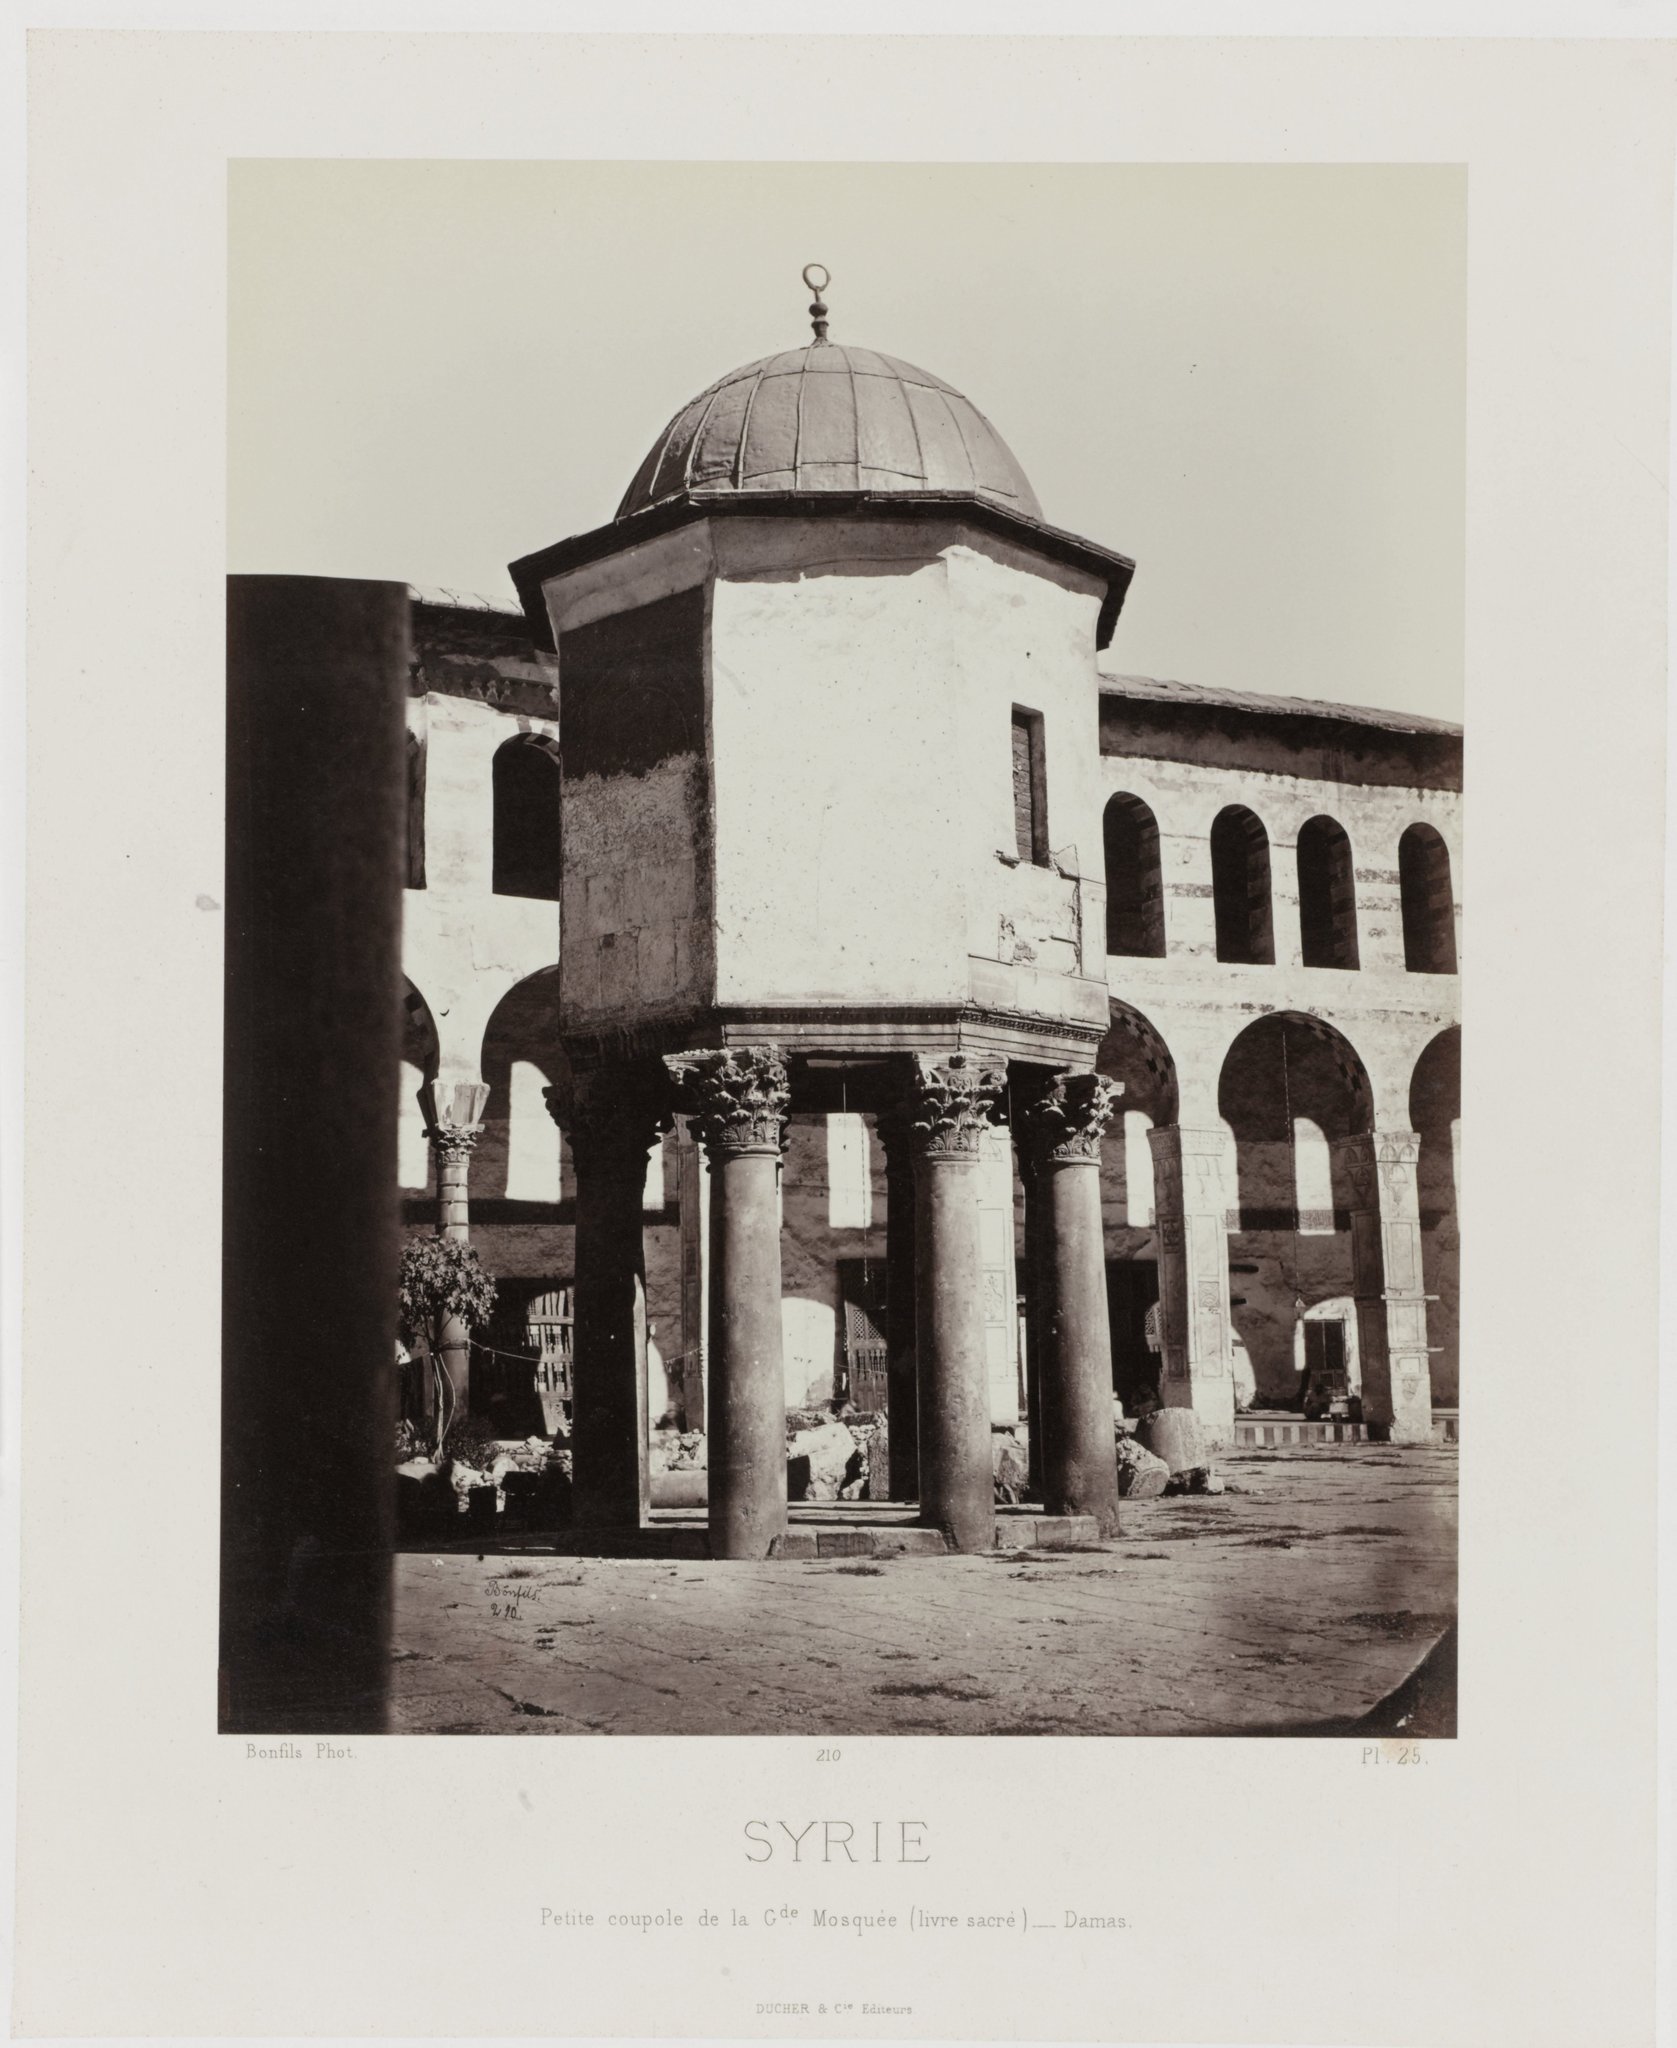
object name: photograph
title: Architecture antique : Égypte, Grèce, Asie Mineure : album de photographies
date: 1872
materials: cardboard, paper, photographic support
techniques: albumen print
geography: paris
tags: damascus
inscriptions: number: ‘Pl. 25’, stamp: ‘Rijksschool voor Kunstnijverheid’, number: ‘Bonfils 210’, title, signature: ‘Bonfils phot’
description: Syrie/Petite coupole de la Gde Mosquée (livre sacré) - Damas, pl. 25.